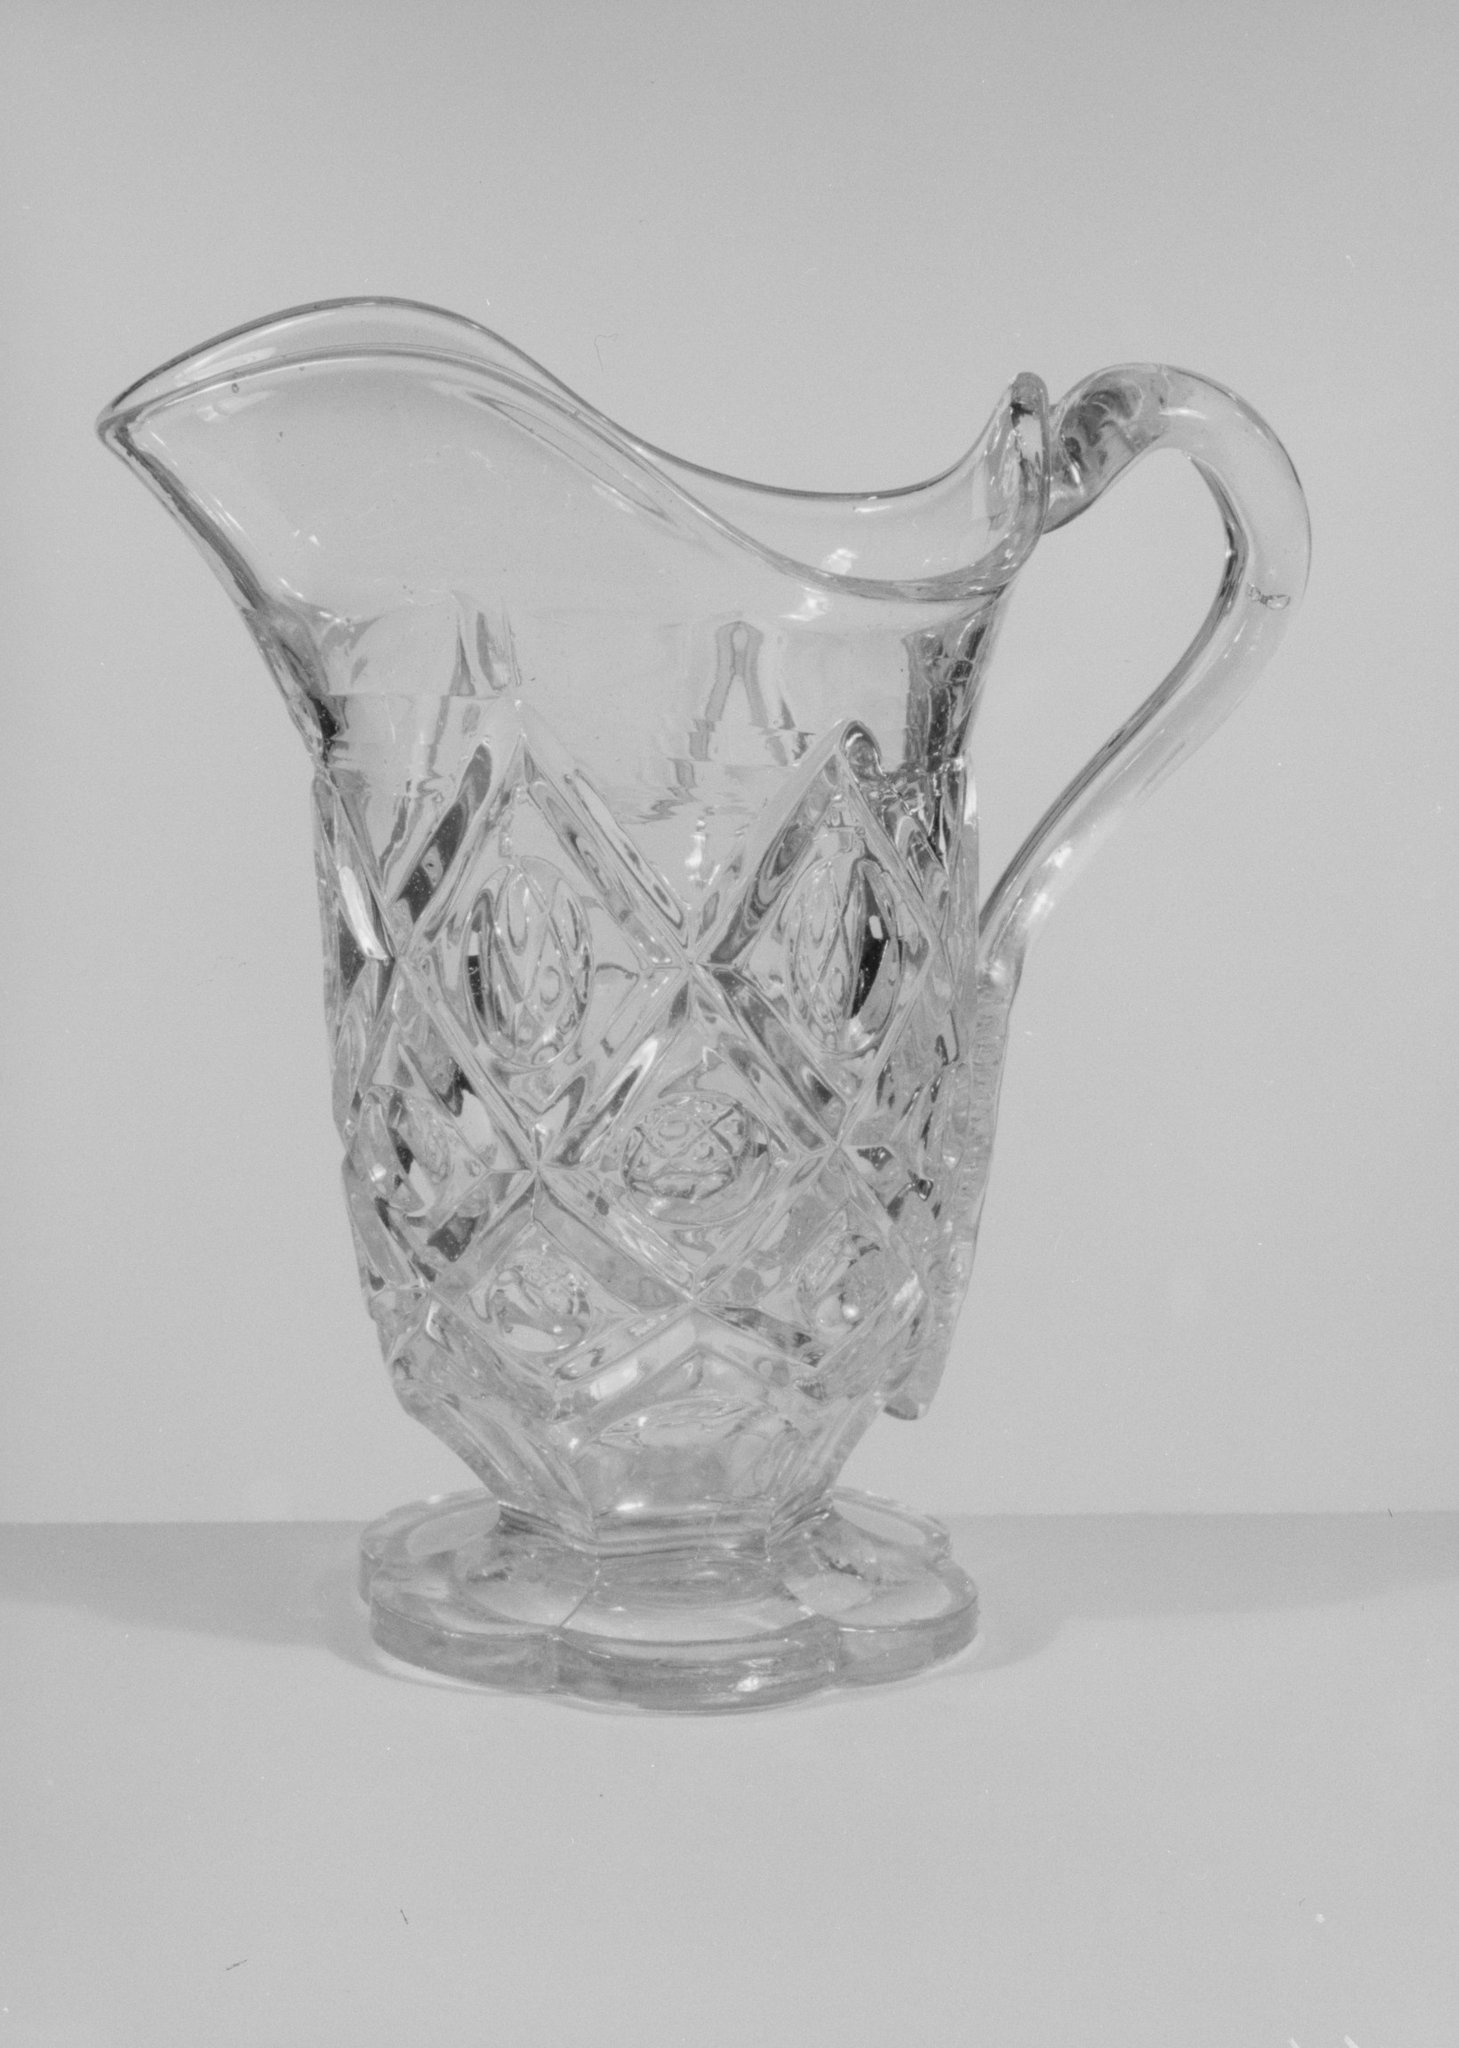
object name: pitcher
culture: american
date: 1850-1860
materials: diamond, glass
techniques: pressed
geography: united states